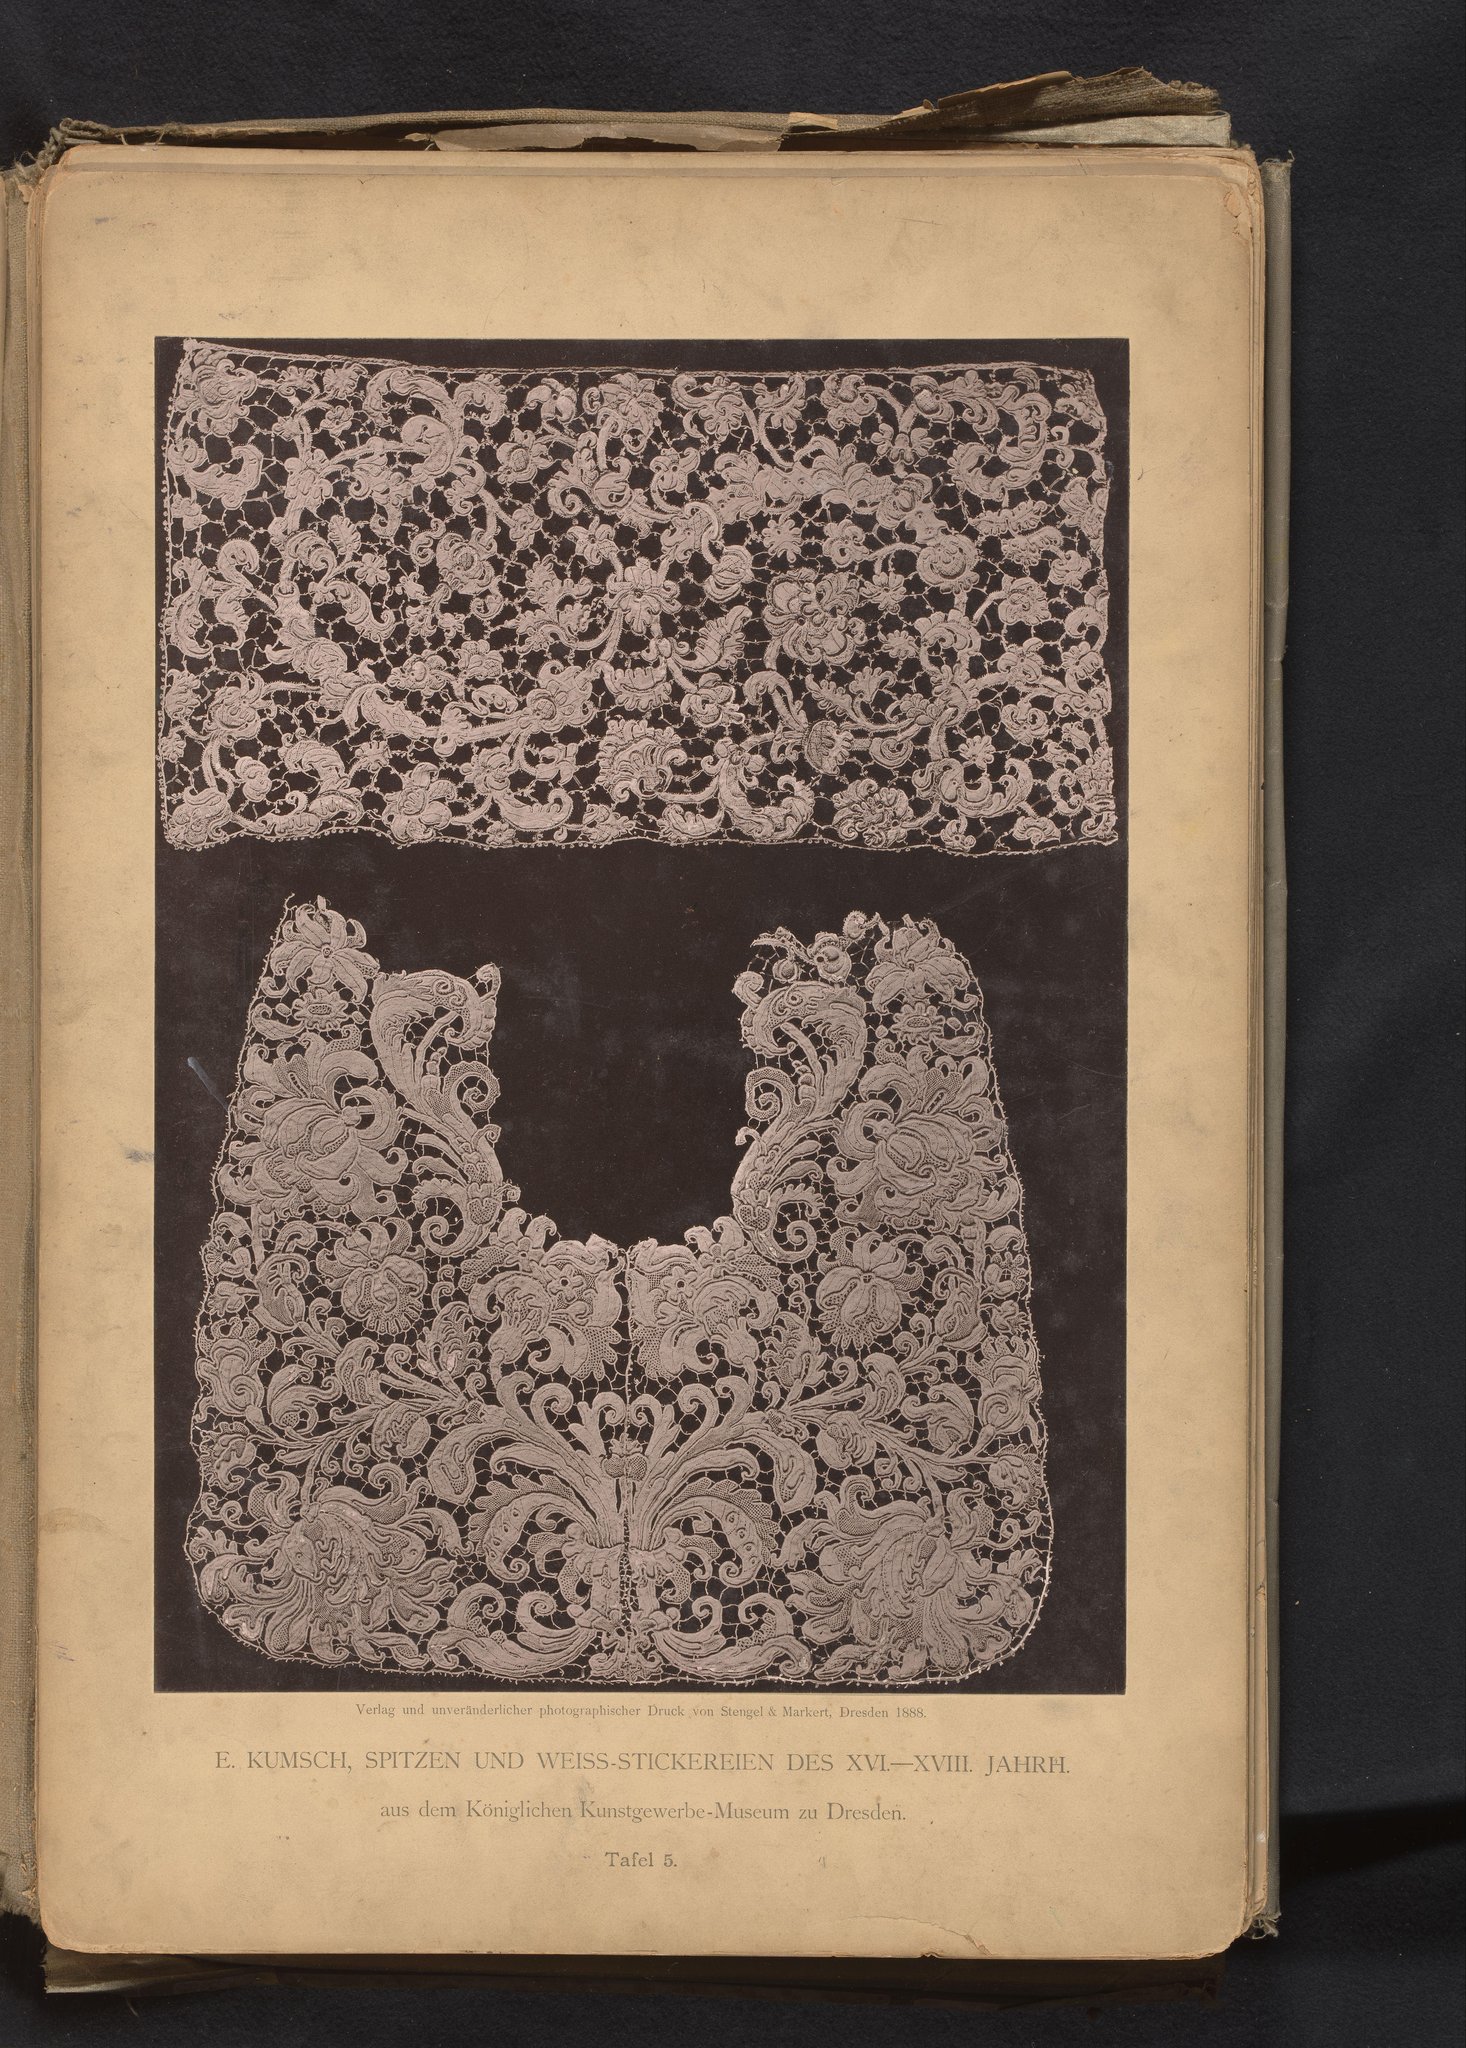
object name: photomechanical print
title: Twee stukken 17de-eeuws kant geproduceerd in Venetië, uit de collectie van het Kunstgewerbemuseum in Dresden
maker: Anonymous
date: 1888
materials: paper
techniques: photograph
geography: dresden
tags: lace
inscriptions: number: ‘Tafel 5.’, inscription: ‘E. KUMSCH, SPITZEN UND WEISS-STICKEREIEN DES XVI.-XVIII. JAHRH./ aus dem Königlichen Kunstgewerbe-Museum zu Dresden’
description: Deze prent maakt deel uit van een omslag met 49 prenten en een lijst van afbeeldingen.